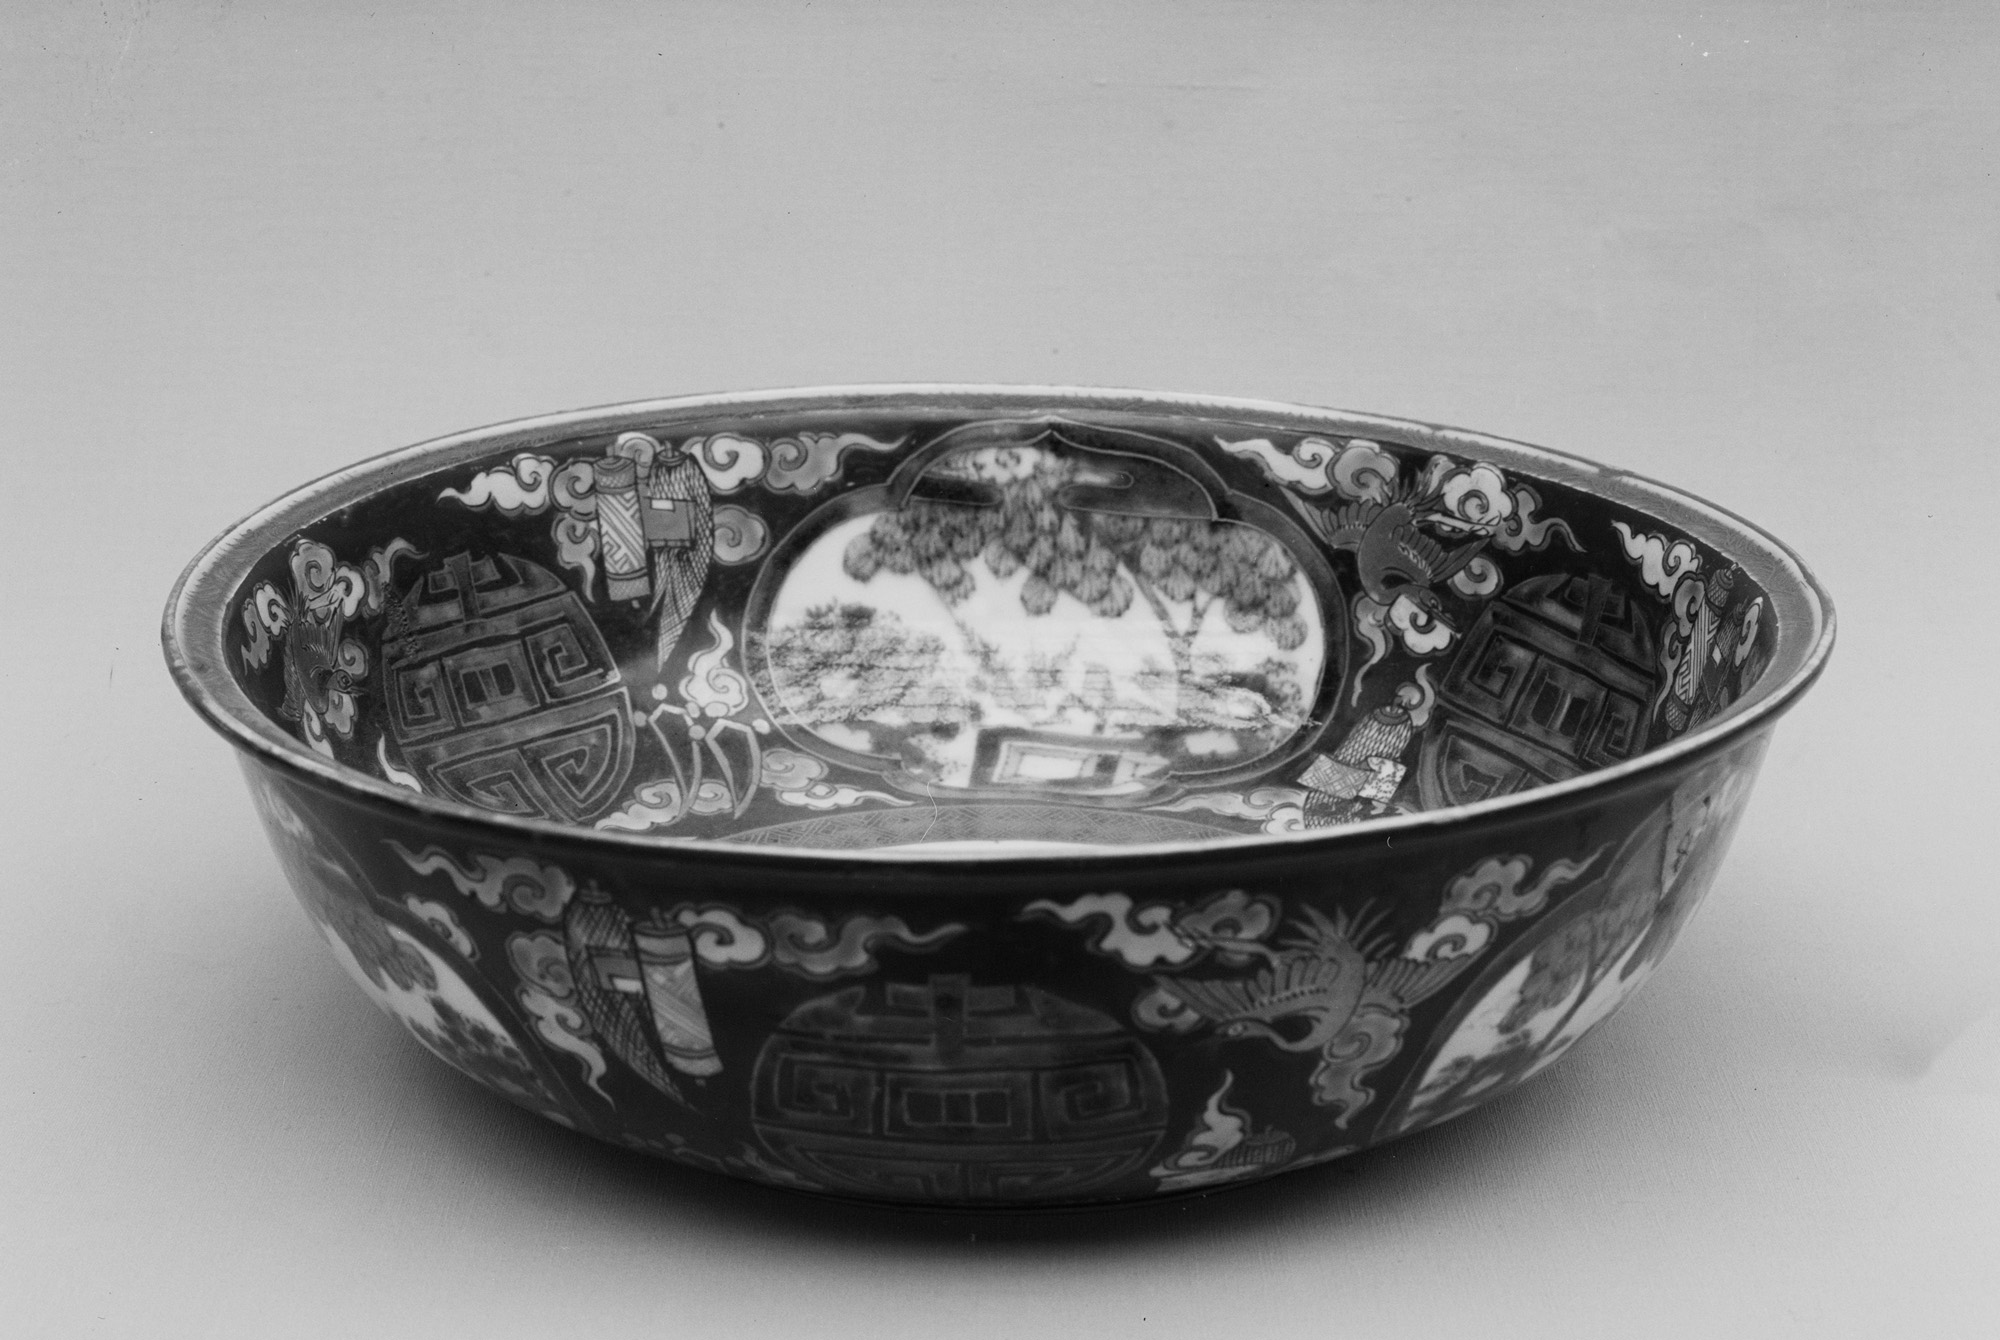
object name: bowl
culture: japanese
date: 1780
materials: enamel, glaze, porcelain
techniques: polychrome